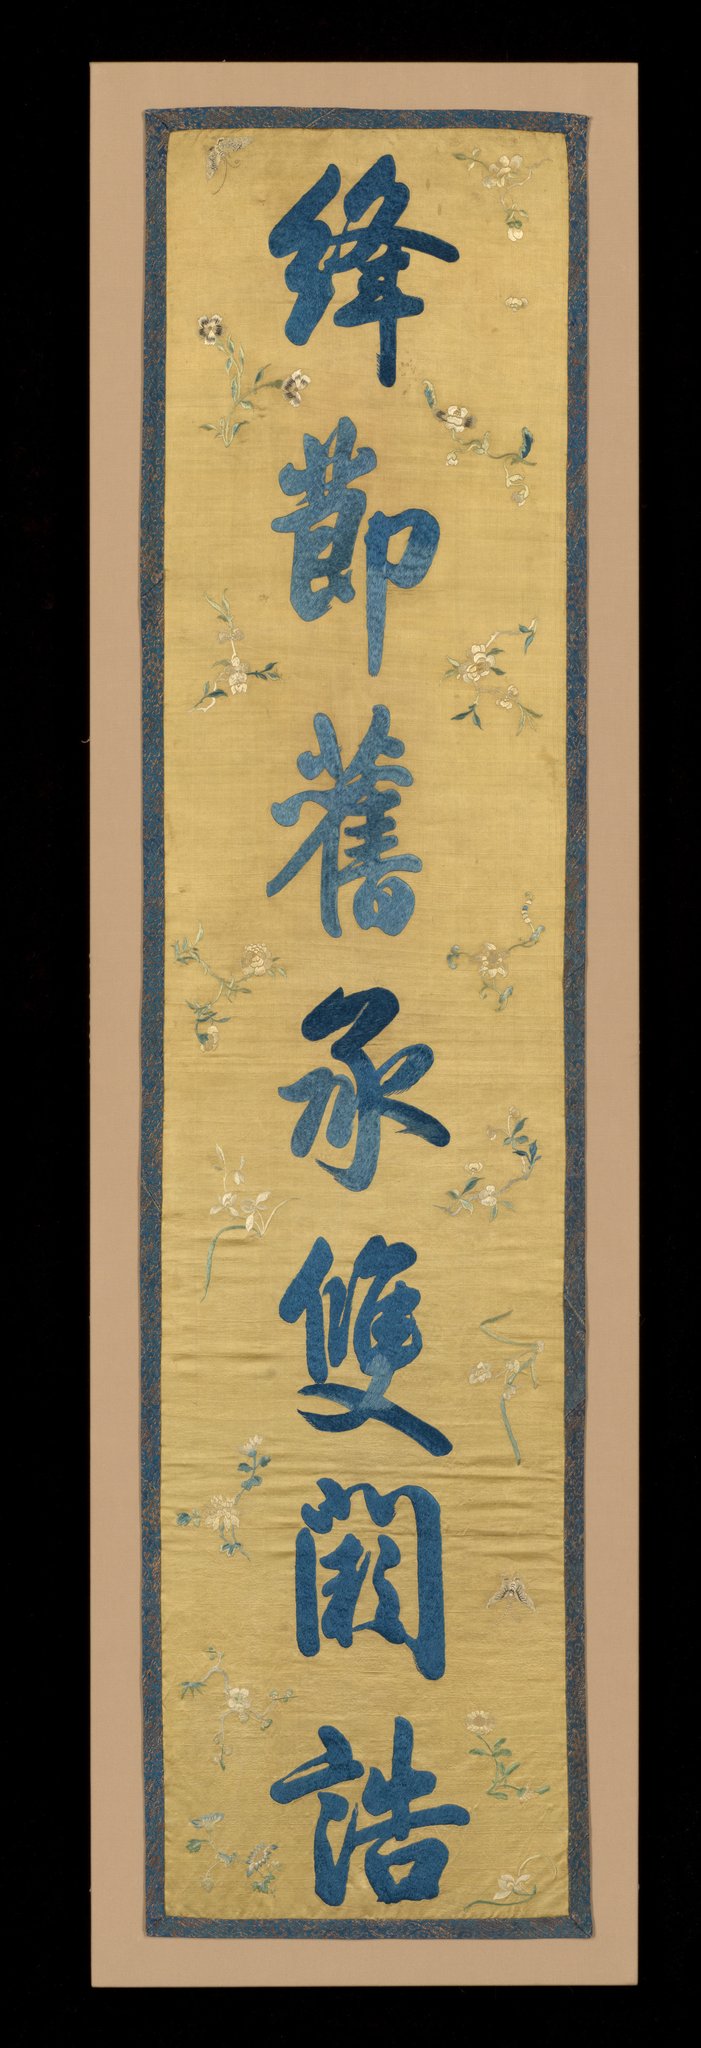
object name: panel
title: Poetic couplet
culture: chinese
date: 1801-1900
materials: silk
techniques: embroidery